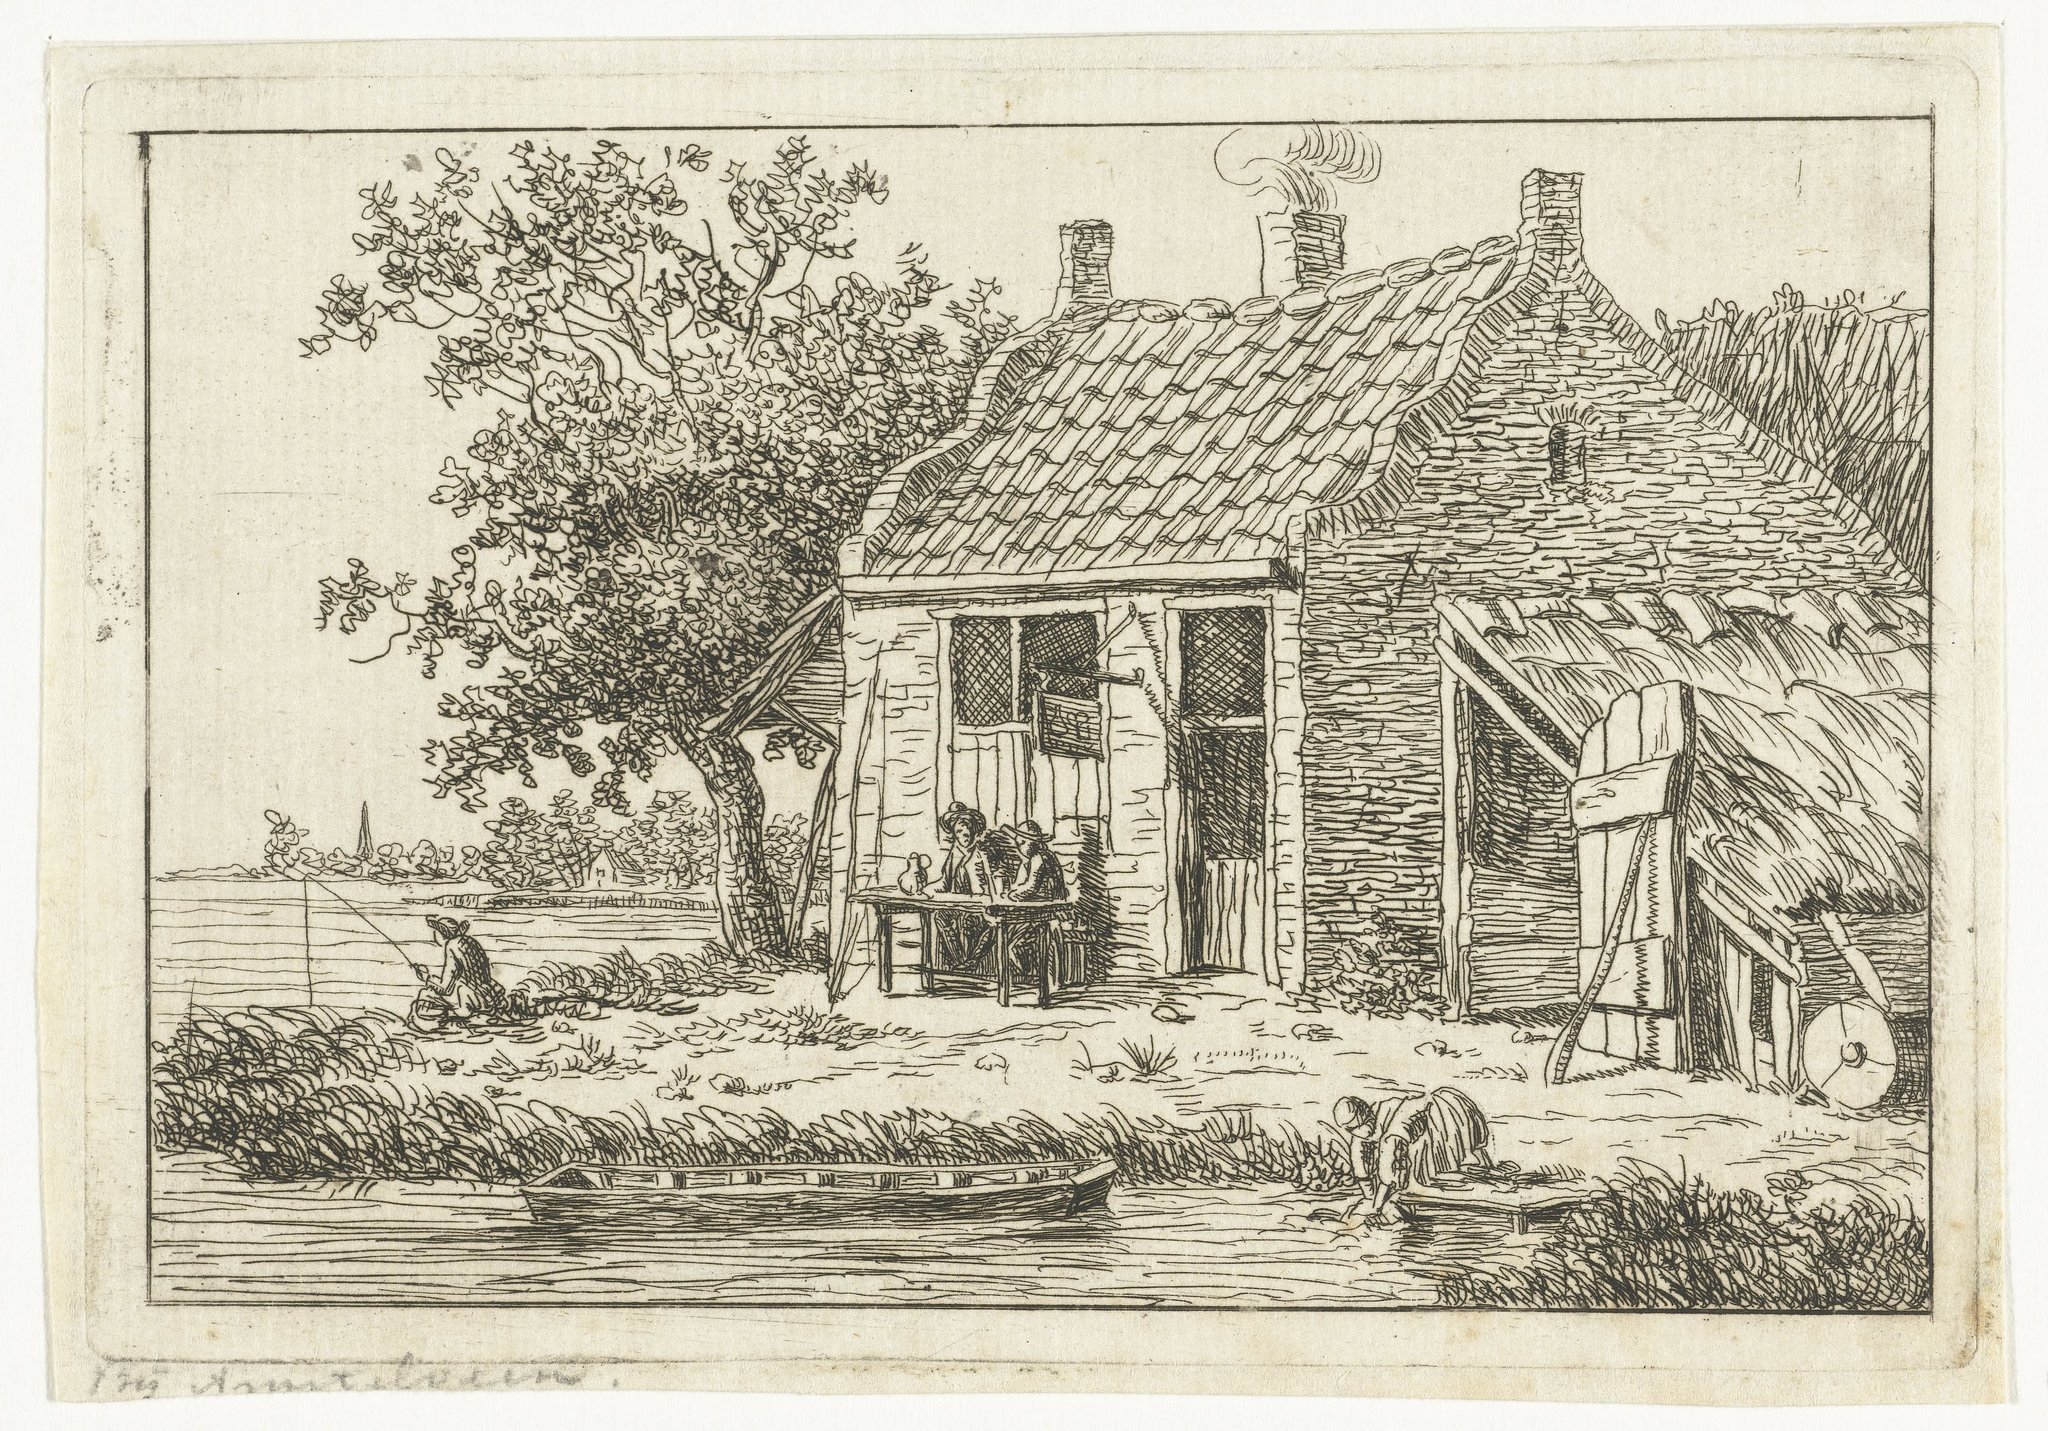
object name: print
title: Herberg aan het water bij Amstelveen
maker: anthonie van den bos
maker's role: draughtsman, print maker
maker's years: 1763-1838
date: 1778-1838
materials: paper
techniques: etching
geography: netherlands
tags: hotel, hostelry, inn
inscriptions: collector's mark: Lugt 2228